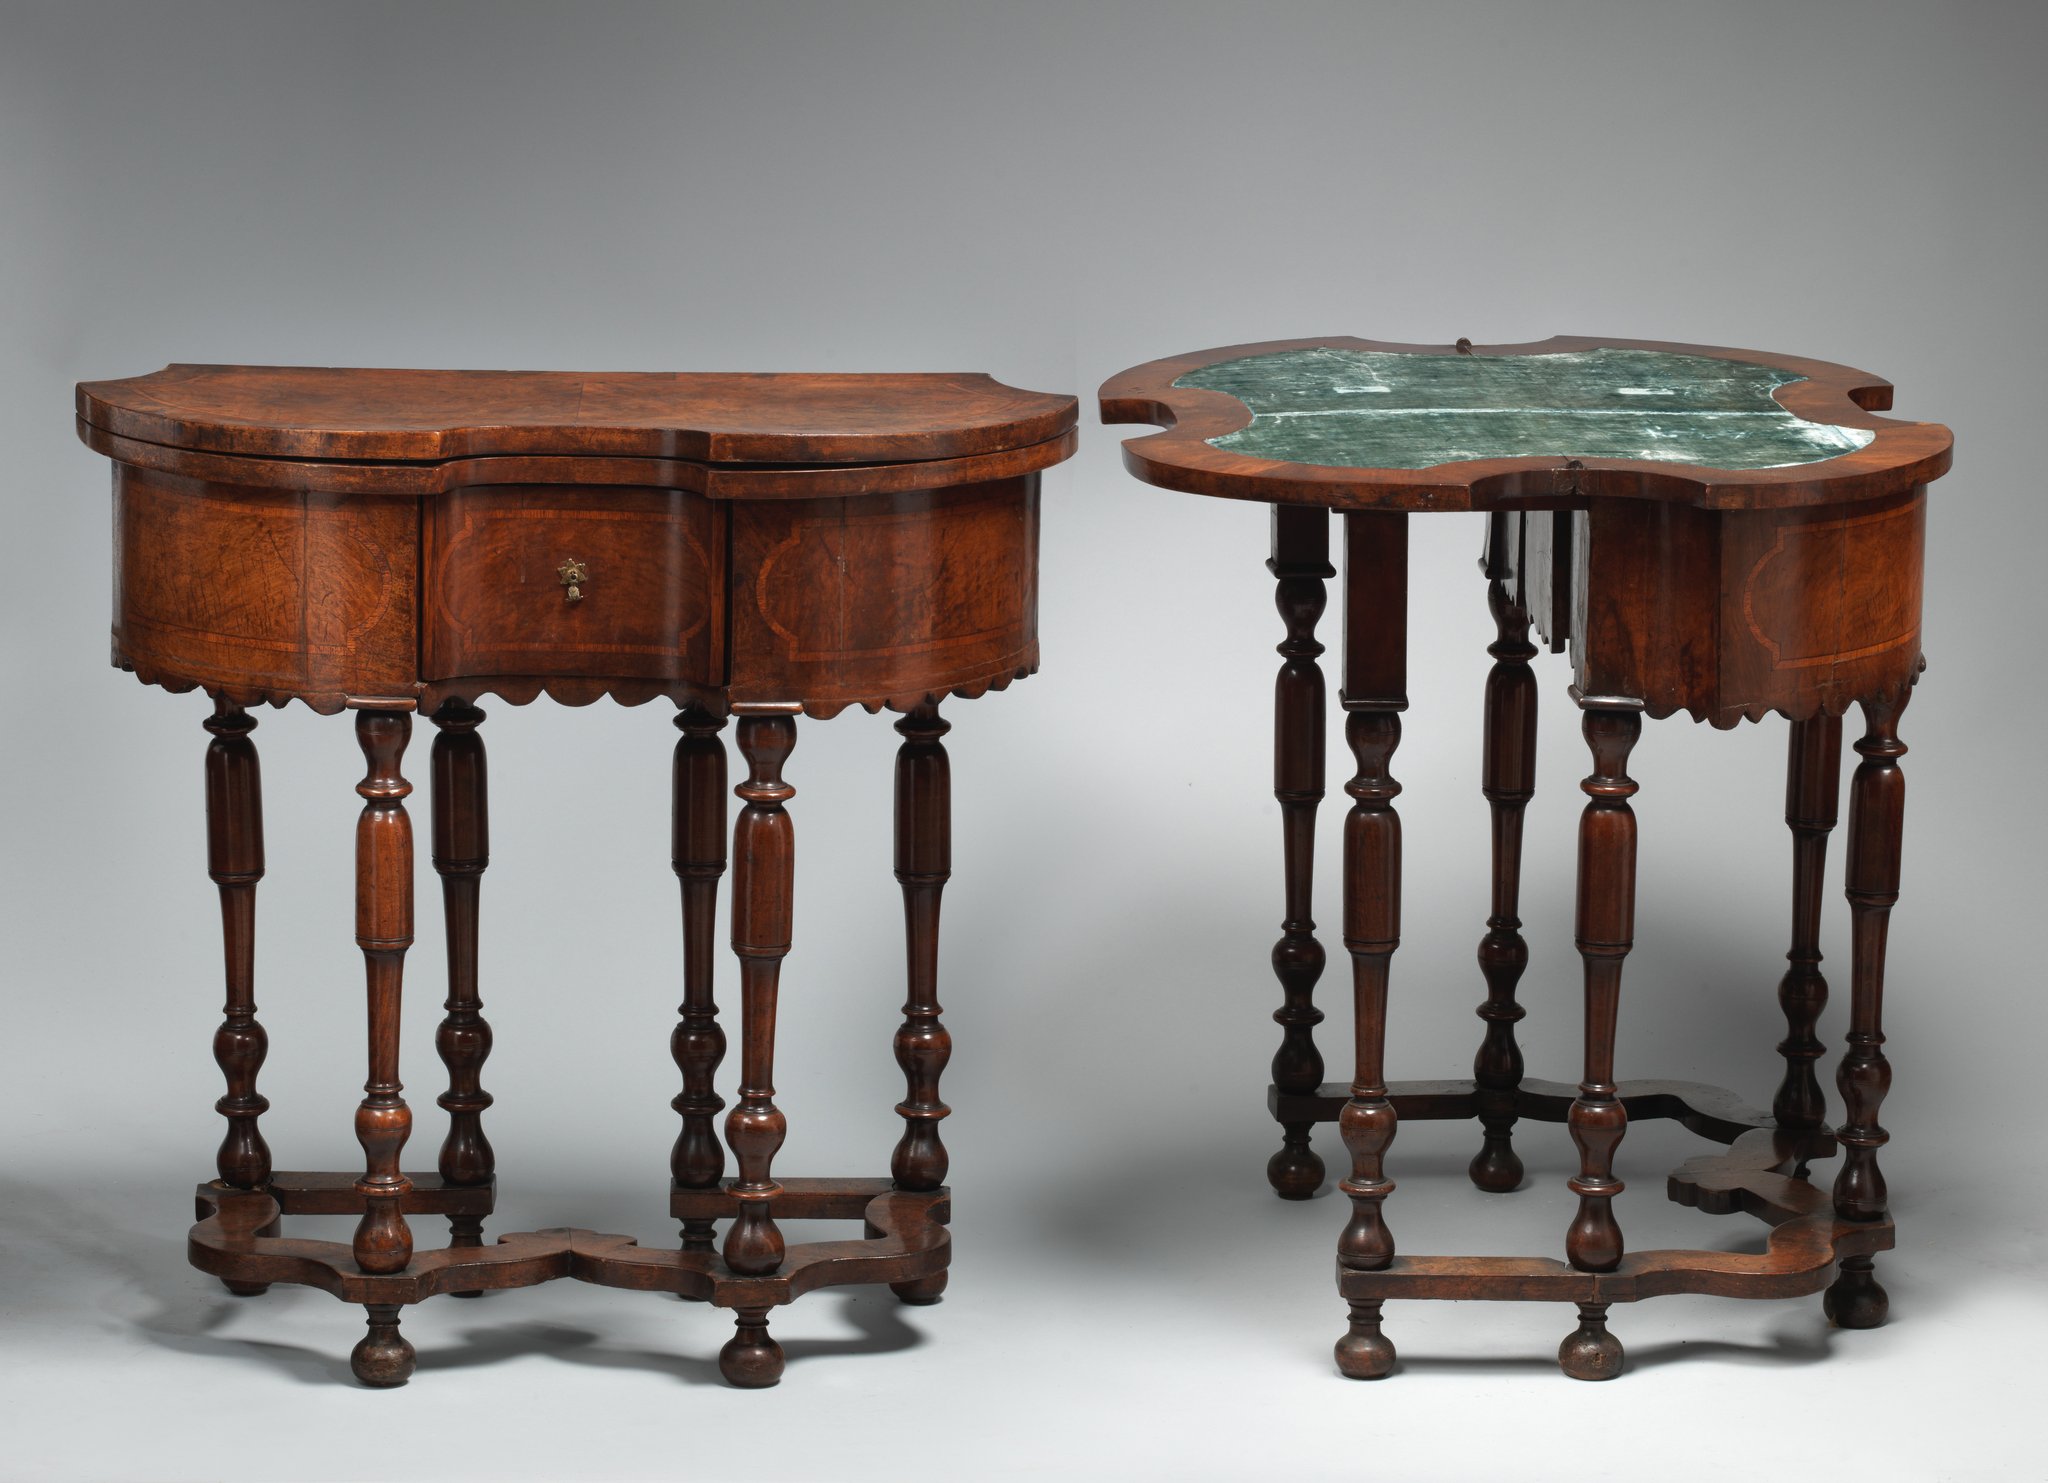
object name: card table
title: Pair of card tables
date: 1700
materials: wood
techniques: veneering